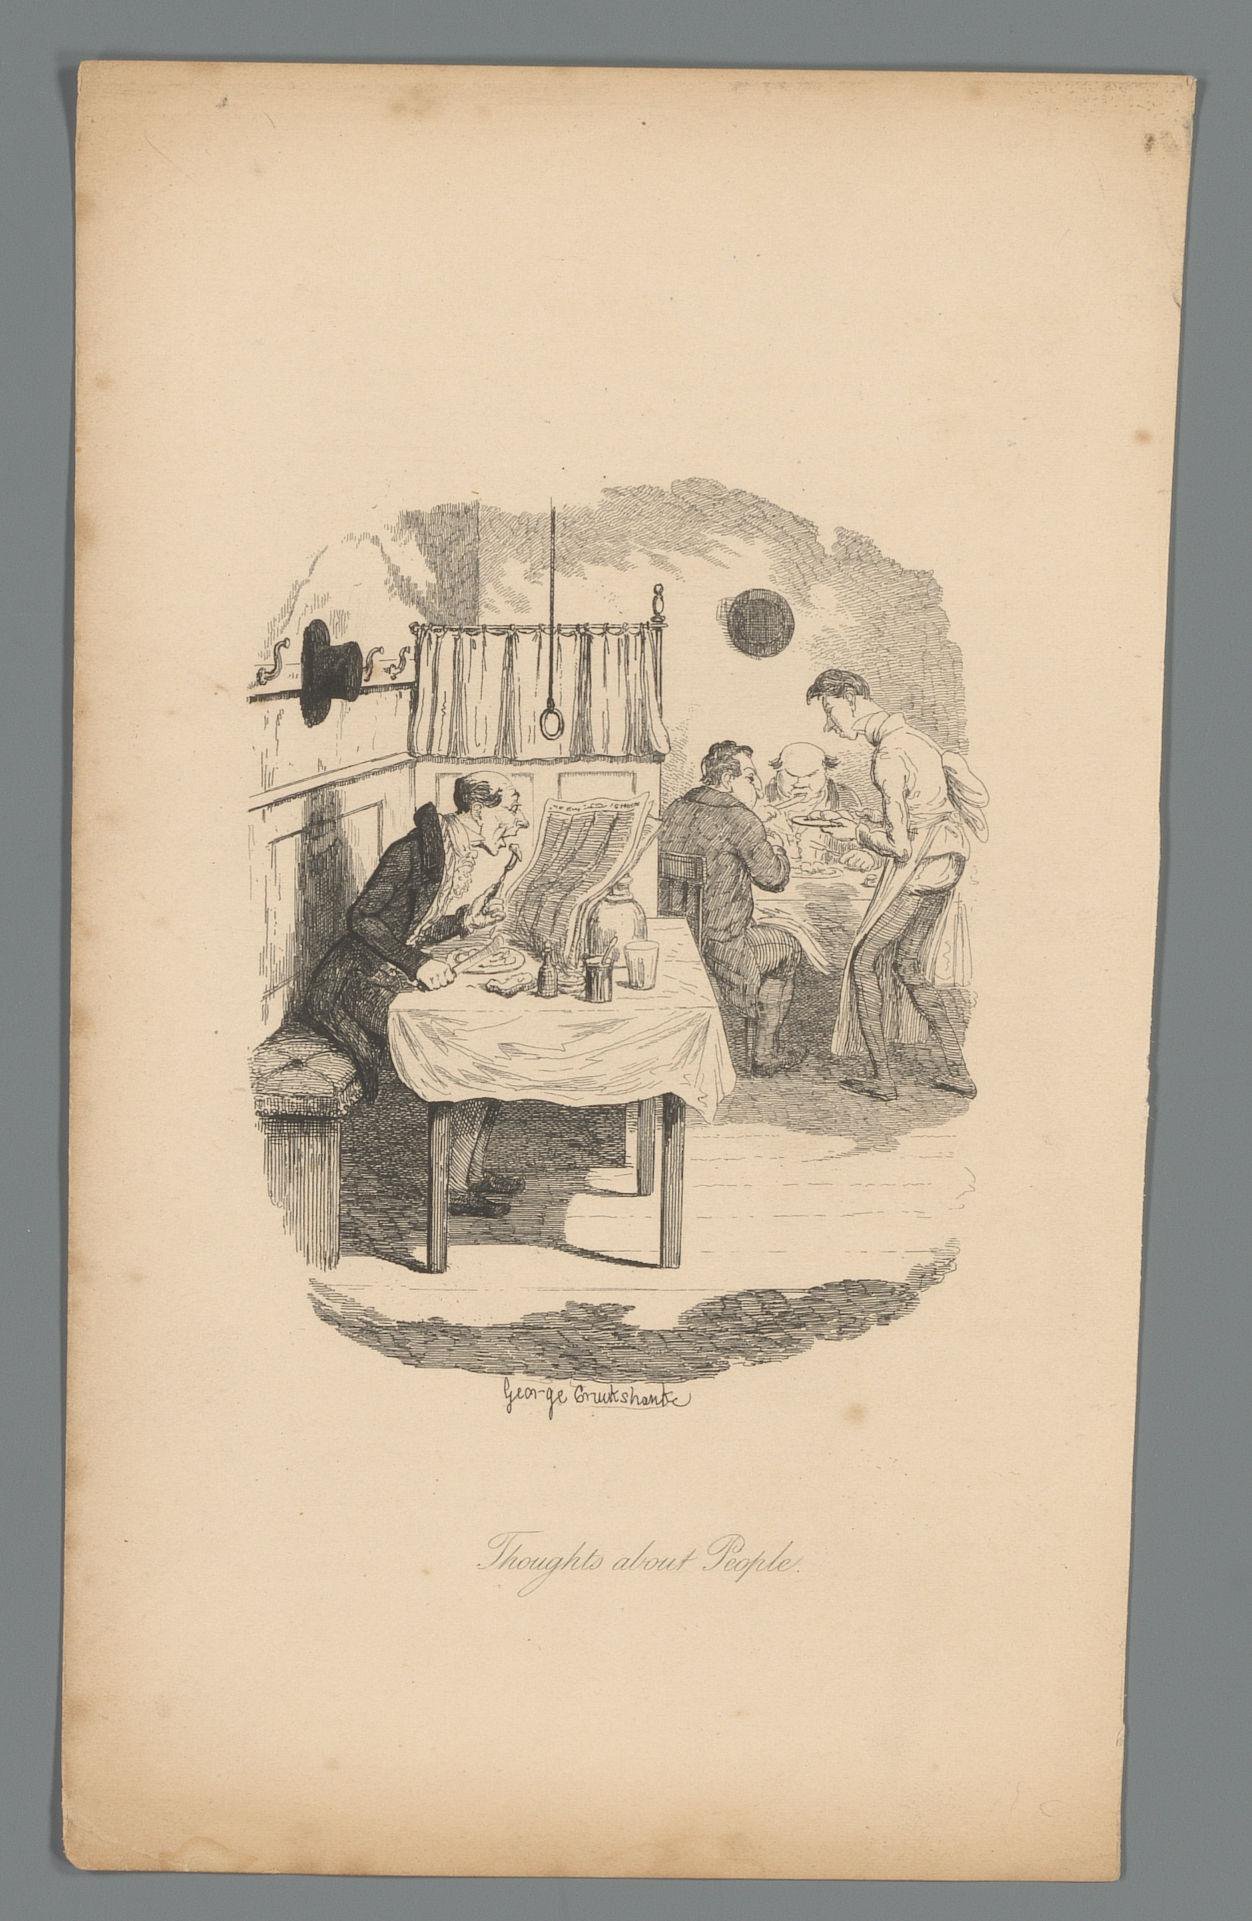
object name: book illustration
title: Krant bij de maaltijd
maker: george cruikshank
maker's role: painter, print maker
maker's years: 1792-1878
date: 1836-1839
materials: paper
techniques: etching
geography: england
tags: reading, restaurant, newspaper, news-sheet, political caricatures and satires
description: Een klerk leest de krant terwijl hij zijn maaltijd tot zich neemt in een eethuis. Illustratie voor een uitgave van Sketches by 'Boz' van Charles Dickens, 1836-1839.